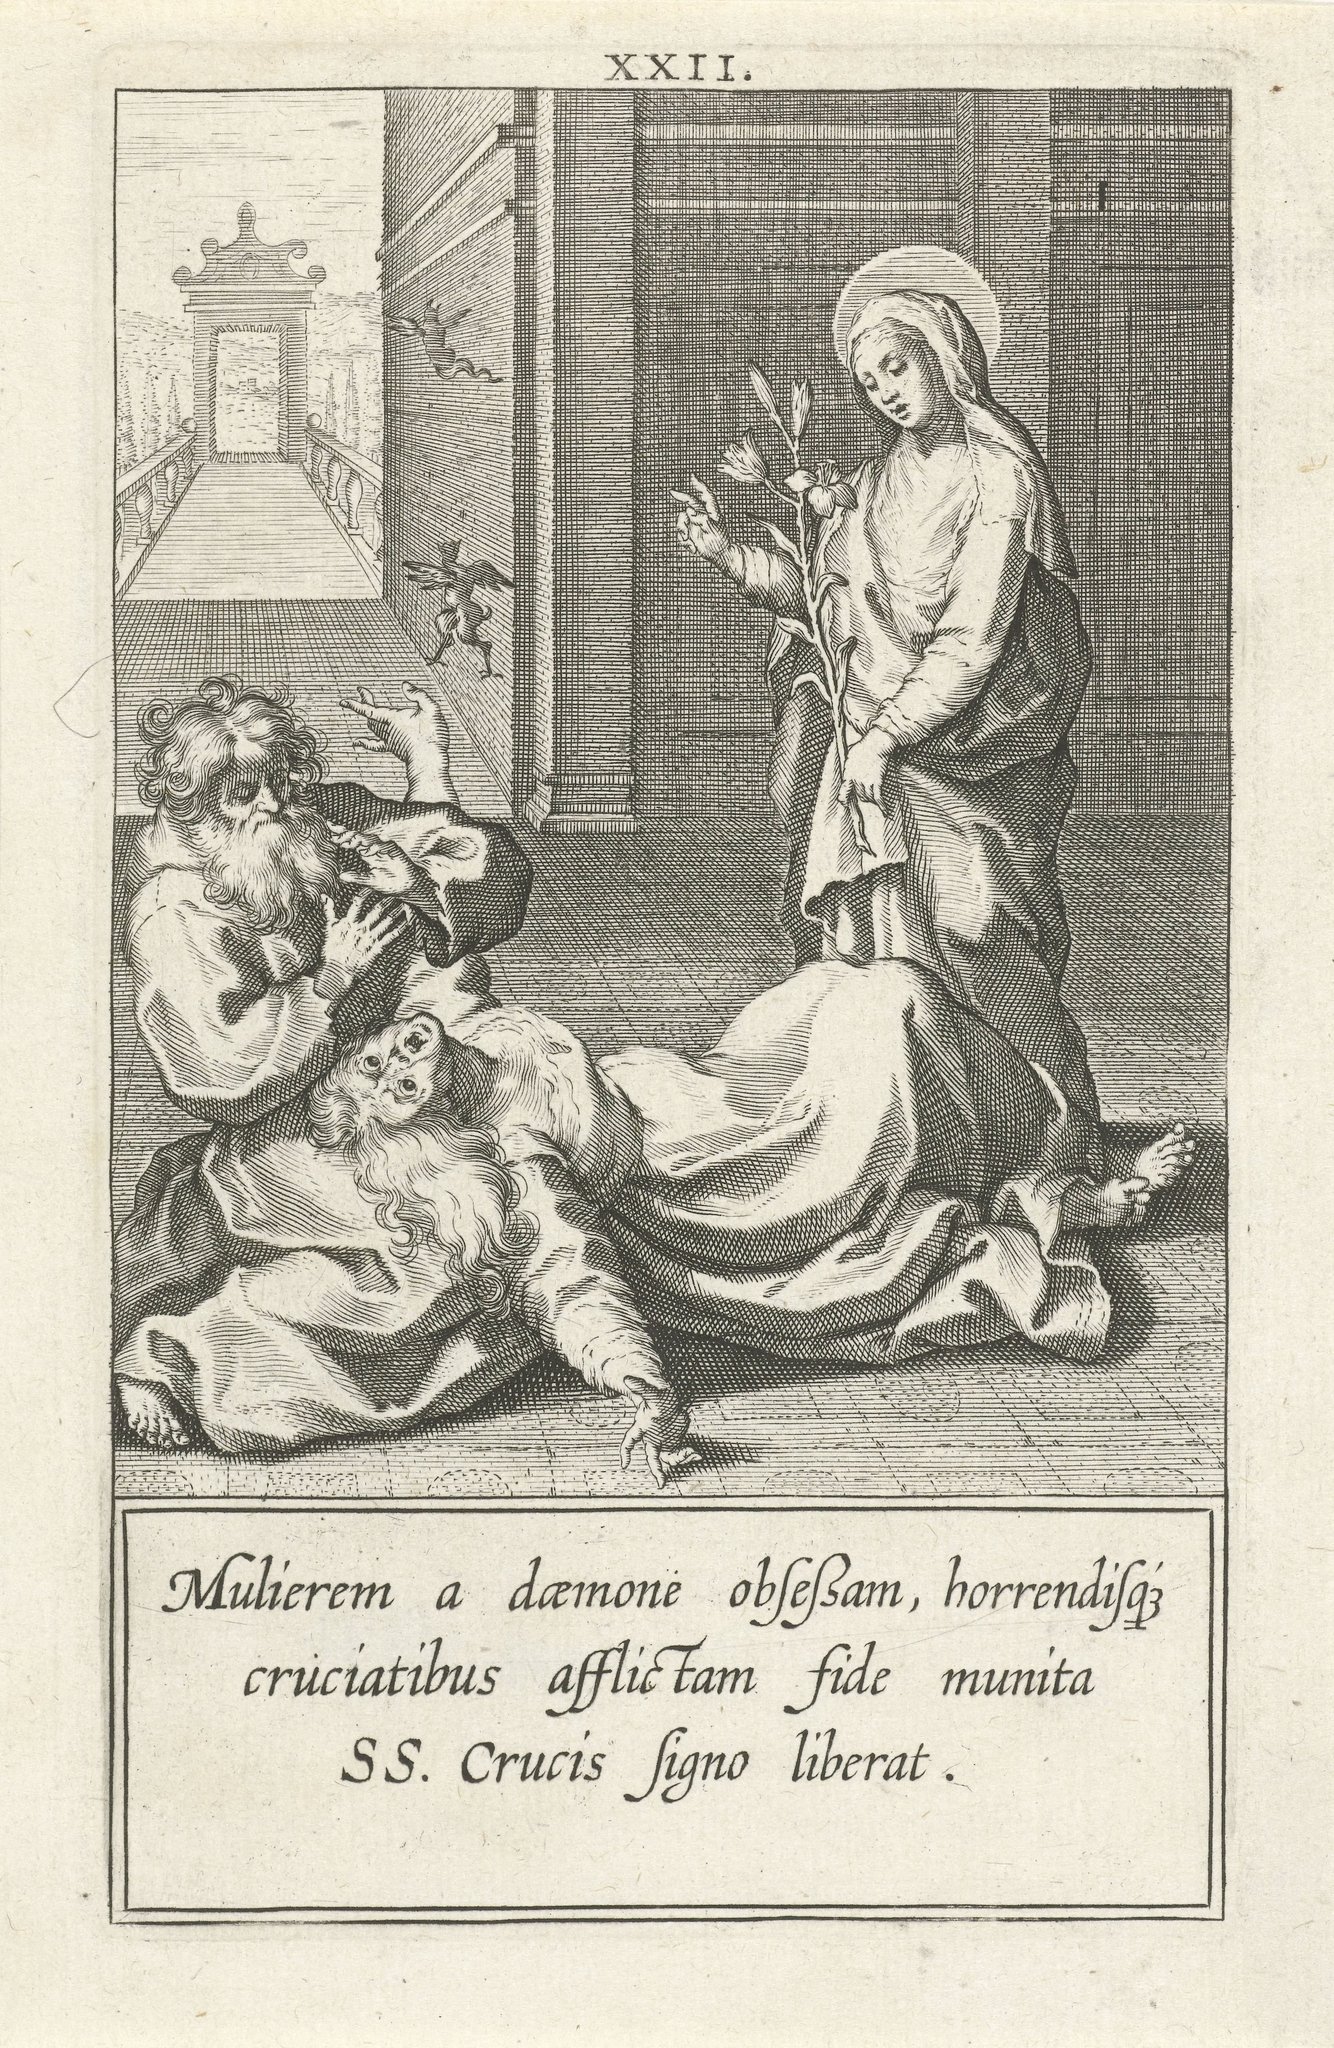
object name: print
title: Catharina verlost een bezetene van haar demonen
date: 1603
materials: paper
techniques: engraving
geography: southern netherlands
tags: miraculous healings of st. catherine of siena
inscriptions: collector's mark: Lugt 2228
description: Een bezetene vrouw windt zich op de vloer. Haar man probeert ze in bedwang te houden. Catharina verlost de vrouw van haar demonen, met haar hand maakt ze een zegenend gebaar. Op de achtergrond zijn twee vluchtende duivels te zien. Deel van een serie over Catharina van Siena bestaande uit een titelprent, een portret en 32 genummerde scènes uit haar leven.